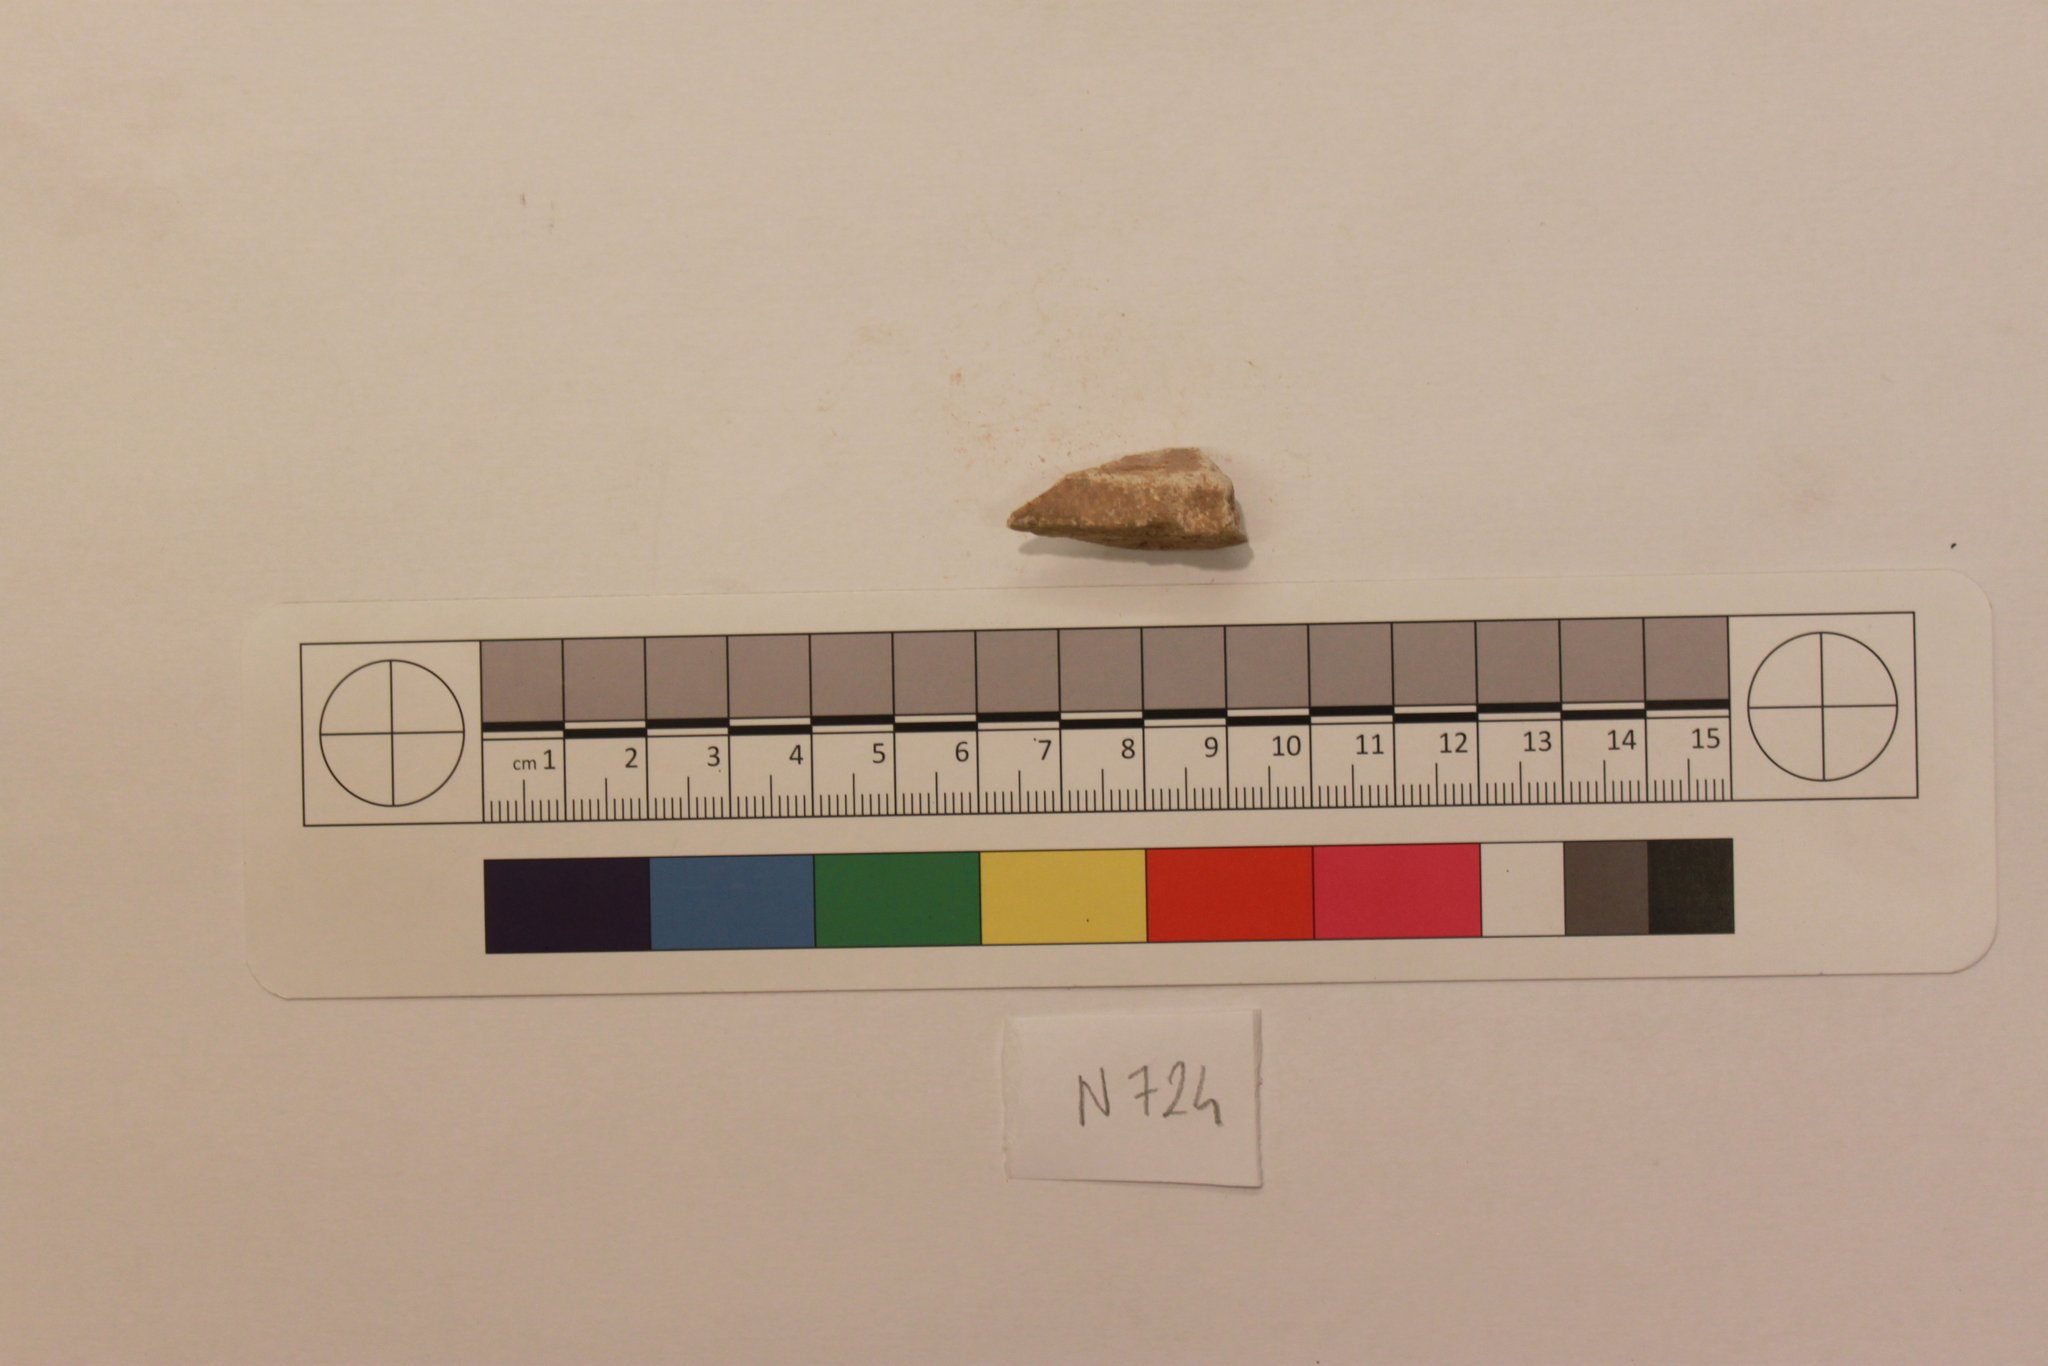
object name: fragment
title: Stucco Fragment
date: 701-1200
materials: plaster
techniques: carving, painting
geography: iran